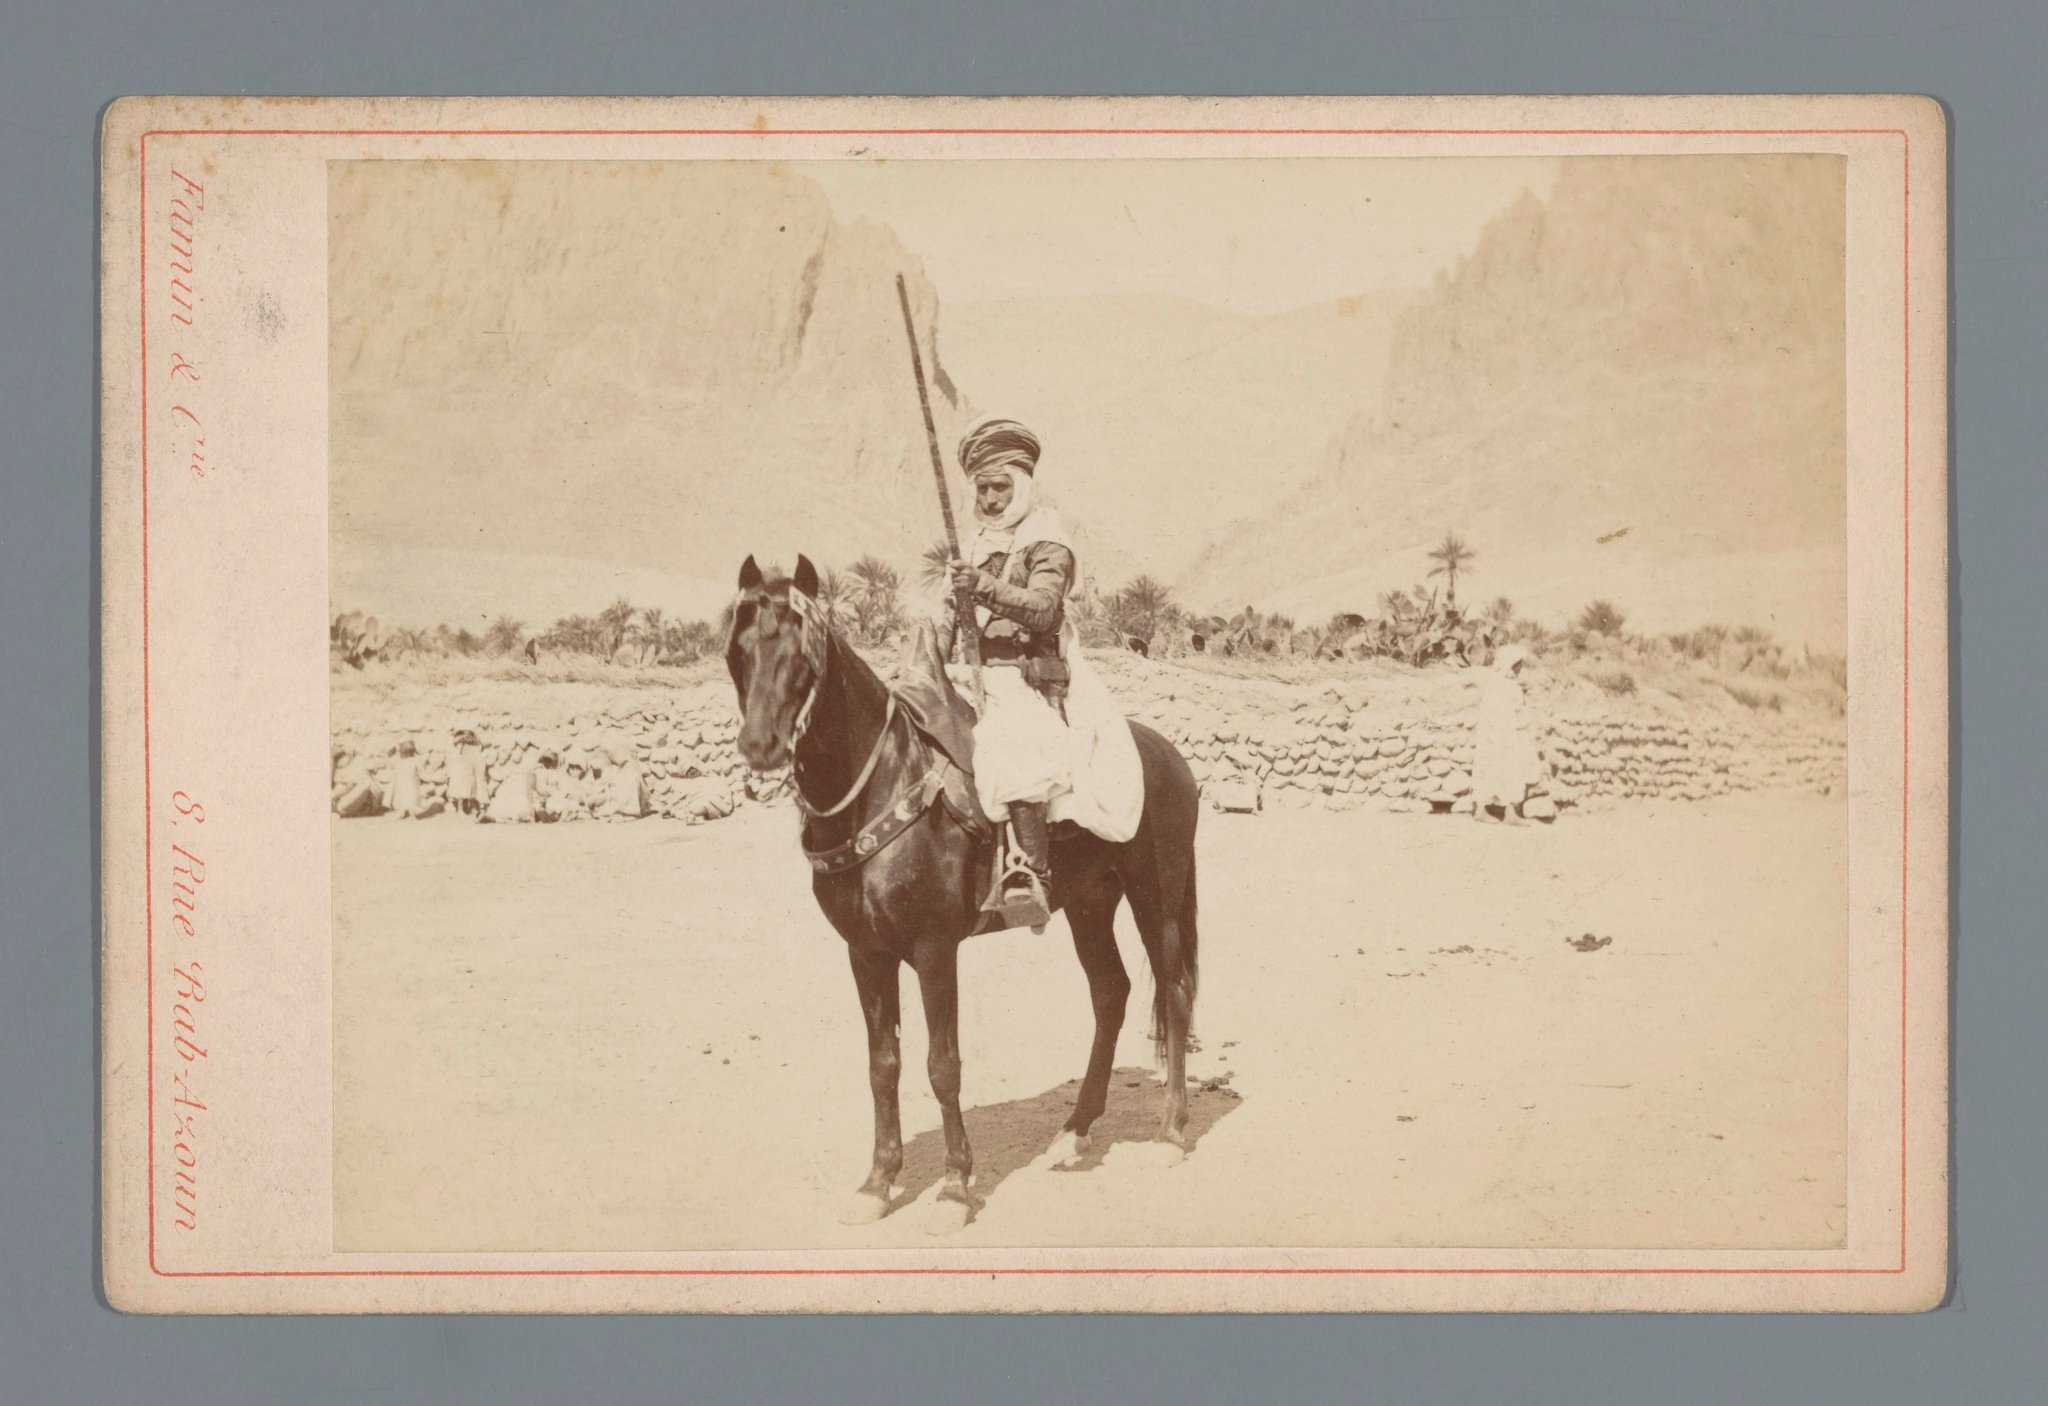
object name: cabinet photograph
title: Arabische man te paard met een geweer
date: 1863-1889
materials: cardboard, photographic support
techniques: albumen print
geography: algeria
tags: anonymous historical person portrayed, firearms: rifle, horse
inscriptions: inscription: ‘Cavalier arabe’, inscription: ‘8, Rue Bab-Azoun’, inscription: ‘Alger/ 8, Rue Bab-Azoun, 8’